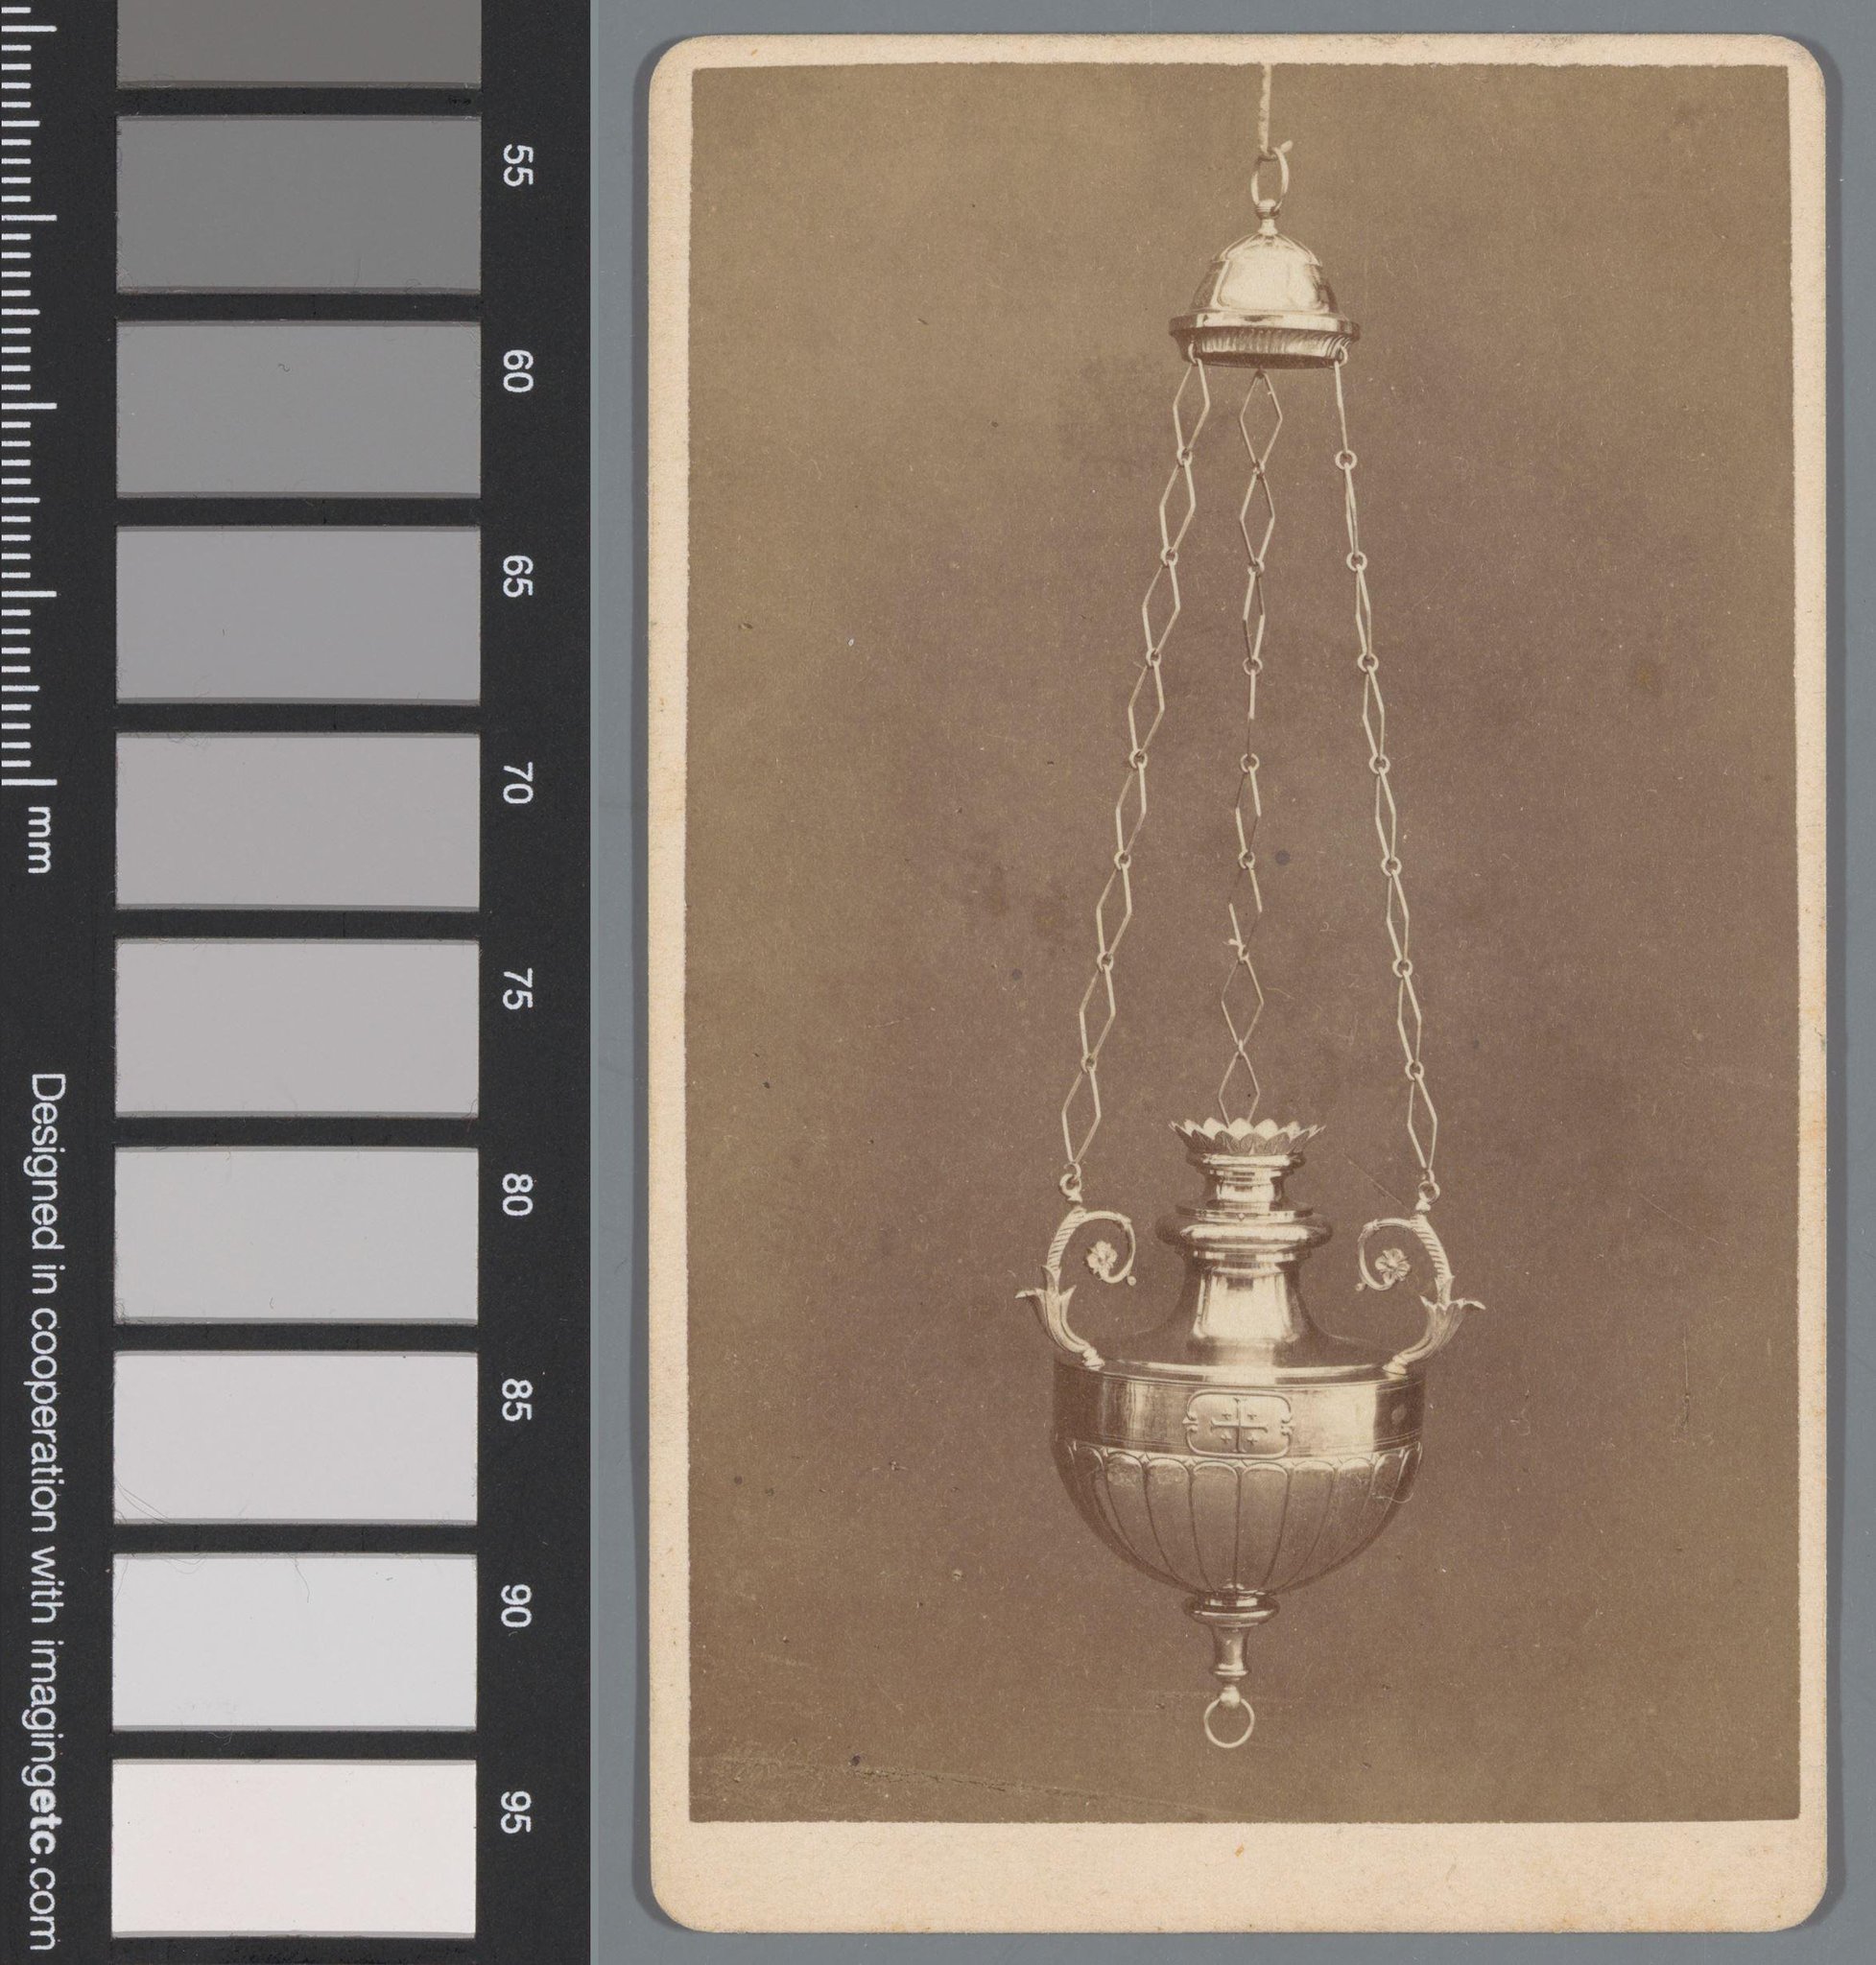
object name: carte de visite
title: Godslamp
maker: giacomo brogi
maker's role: fotograaf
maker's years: 1822-1881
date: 1865-1881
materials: cardboard, paper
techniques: albumen print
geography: florence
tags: altarlamp, altar fire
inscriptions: inscription: ‘Giacomo Brogi/ Fotografo-editore./ 15, Lung Arno delle Grazie/ Firenze./ Estese collezioni/ di Vedute d'Italia, d'Egitto e di Palestina/ edite in quattro formati./ Fotografie dei Disegni della R. Galleria di Firenze/ riprodotte dagli originali./ Grandissimi Panorama di un sol pezzo./ Grandiosa collezione delle principali dipinture/ delle Gallerie d'Europa.’